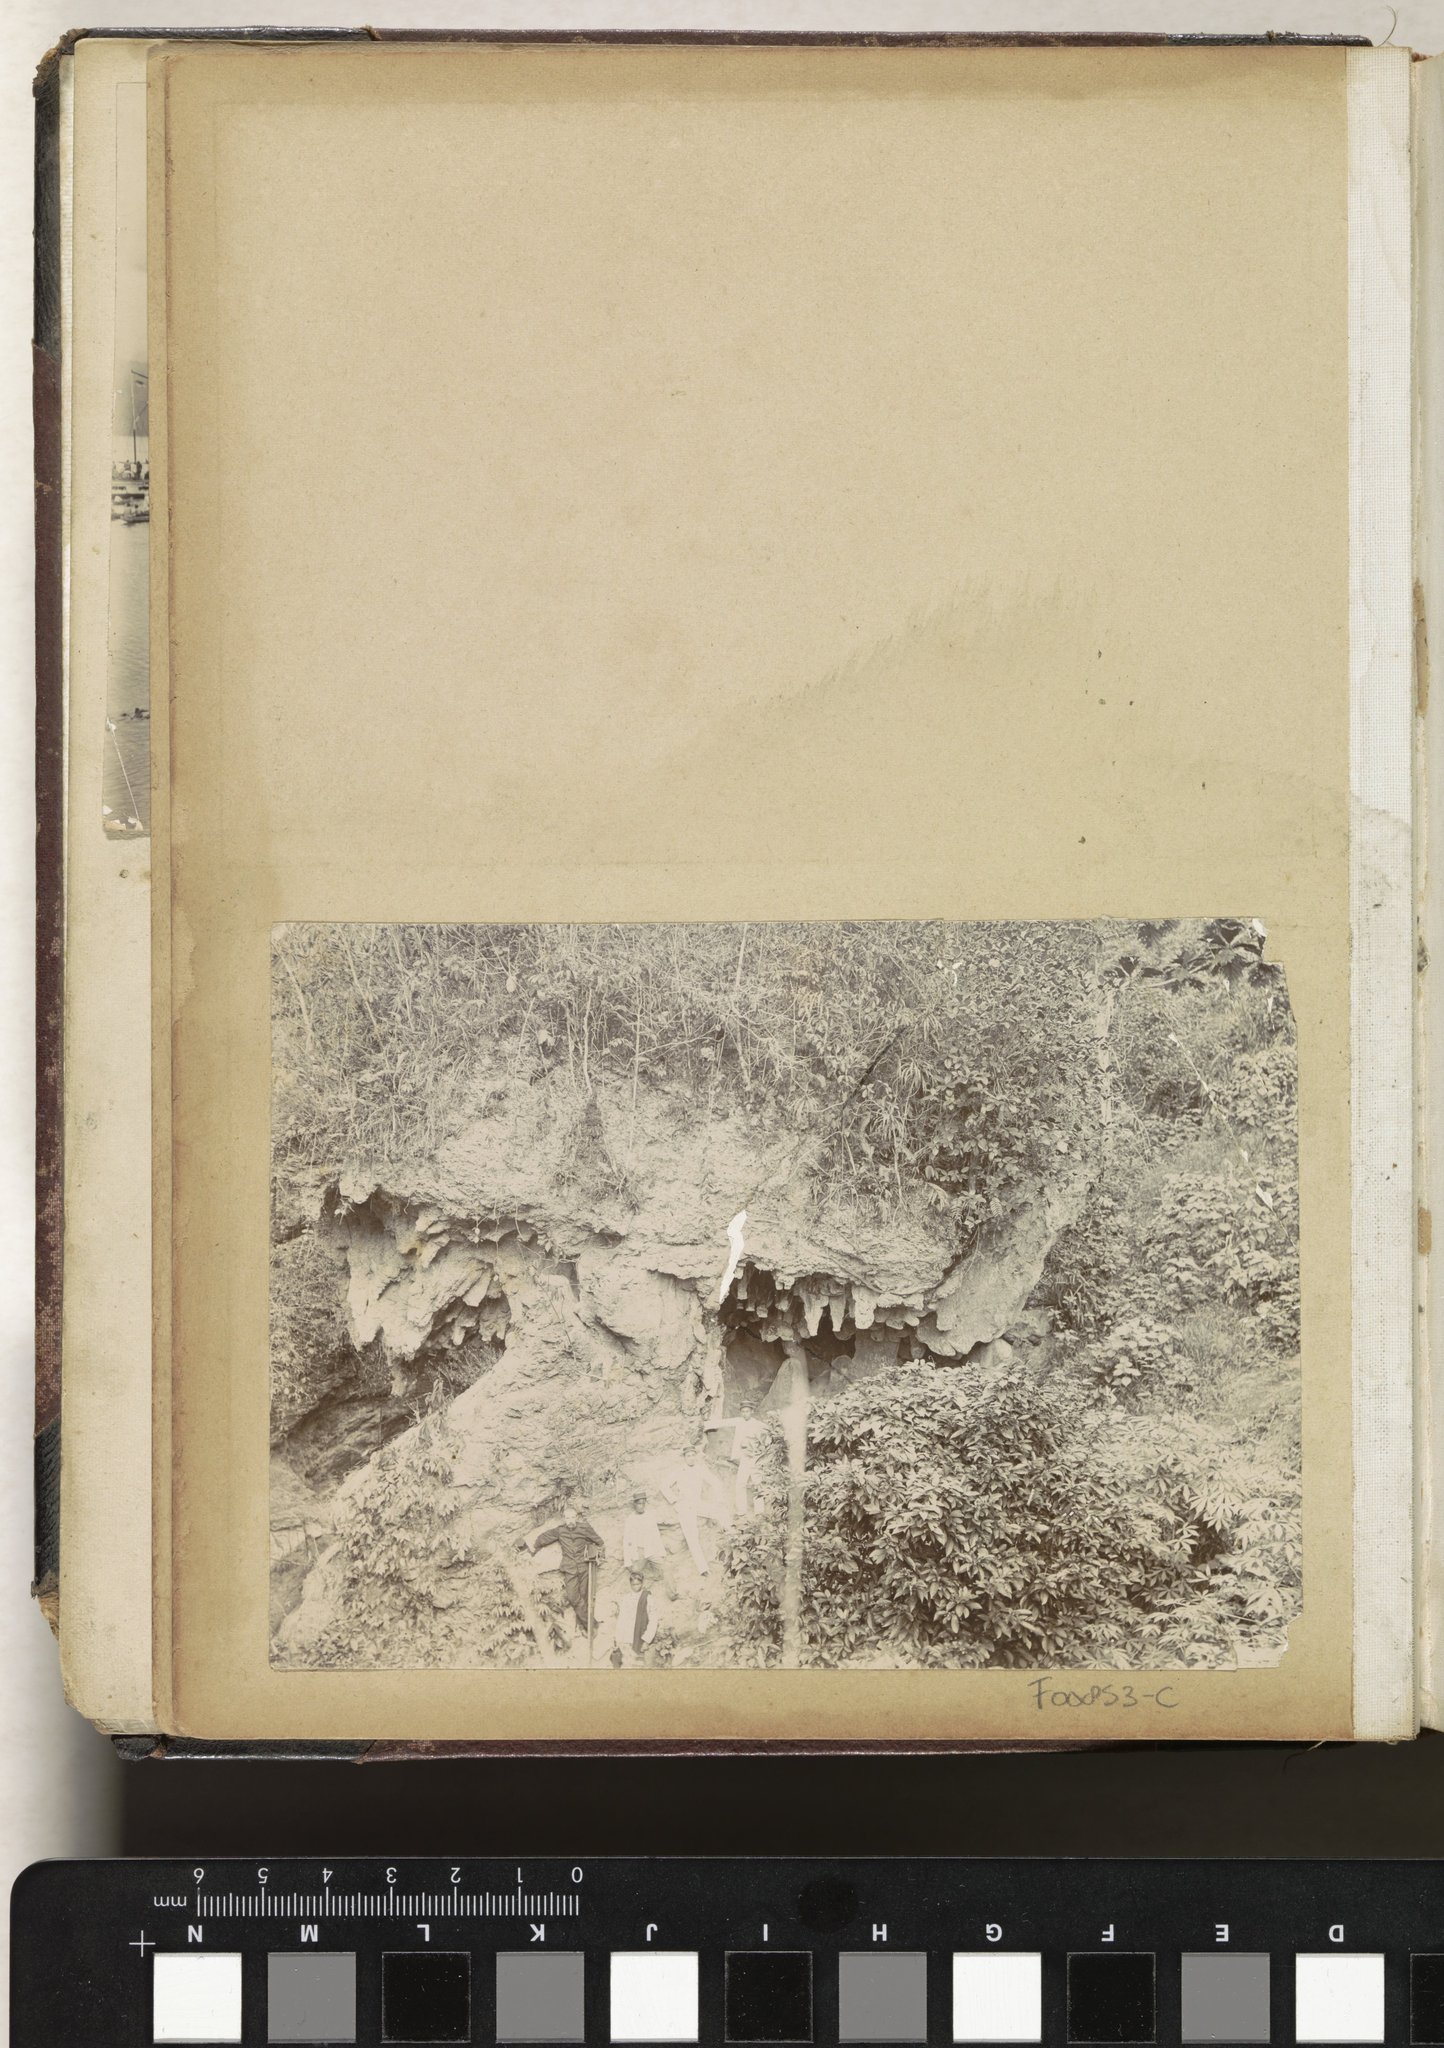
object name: album leaf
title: Mannen bij Hangende Steen in Batoe Gantong op Ambon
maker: Anonymous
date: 1900-1920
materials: cardboard, paper, photographic support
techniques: daylight paper print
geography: ambon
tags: rock-formations, dutch east indies, the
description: Onderdeel van Reisalbum met foto's van Ambon.